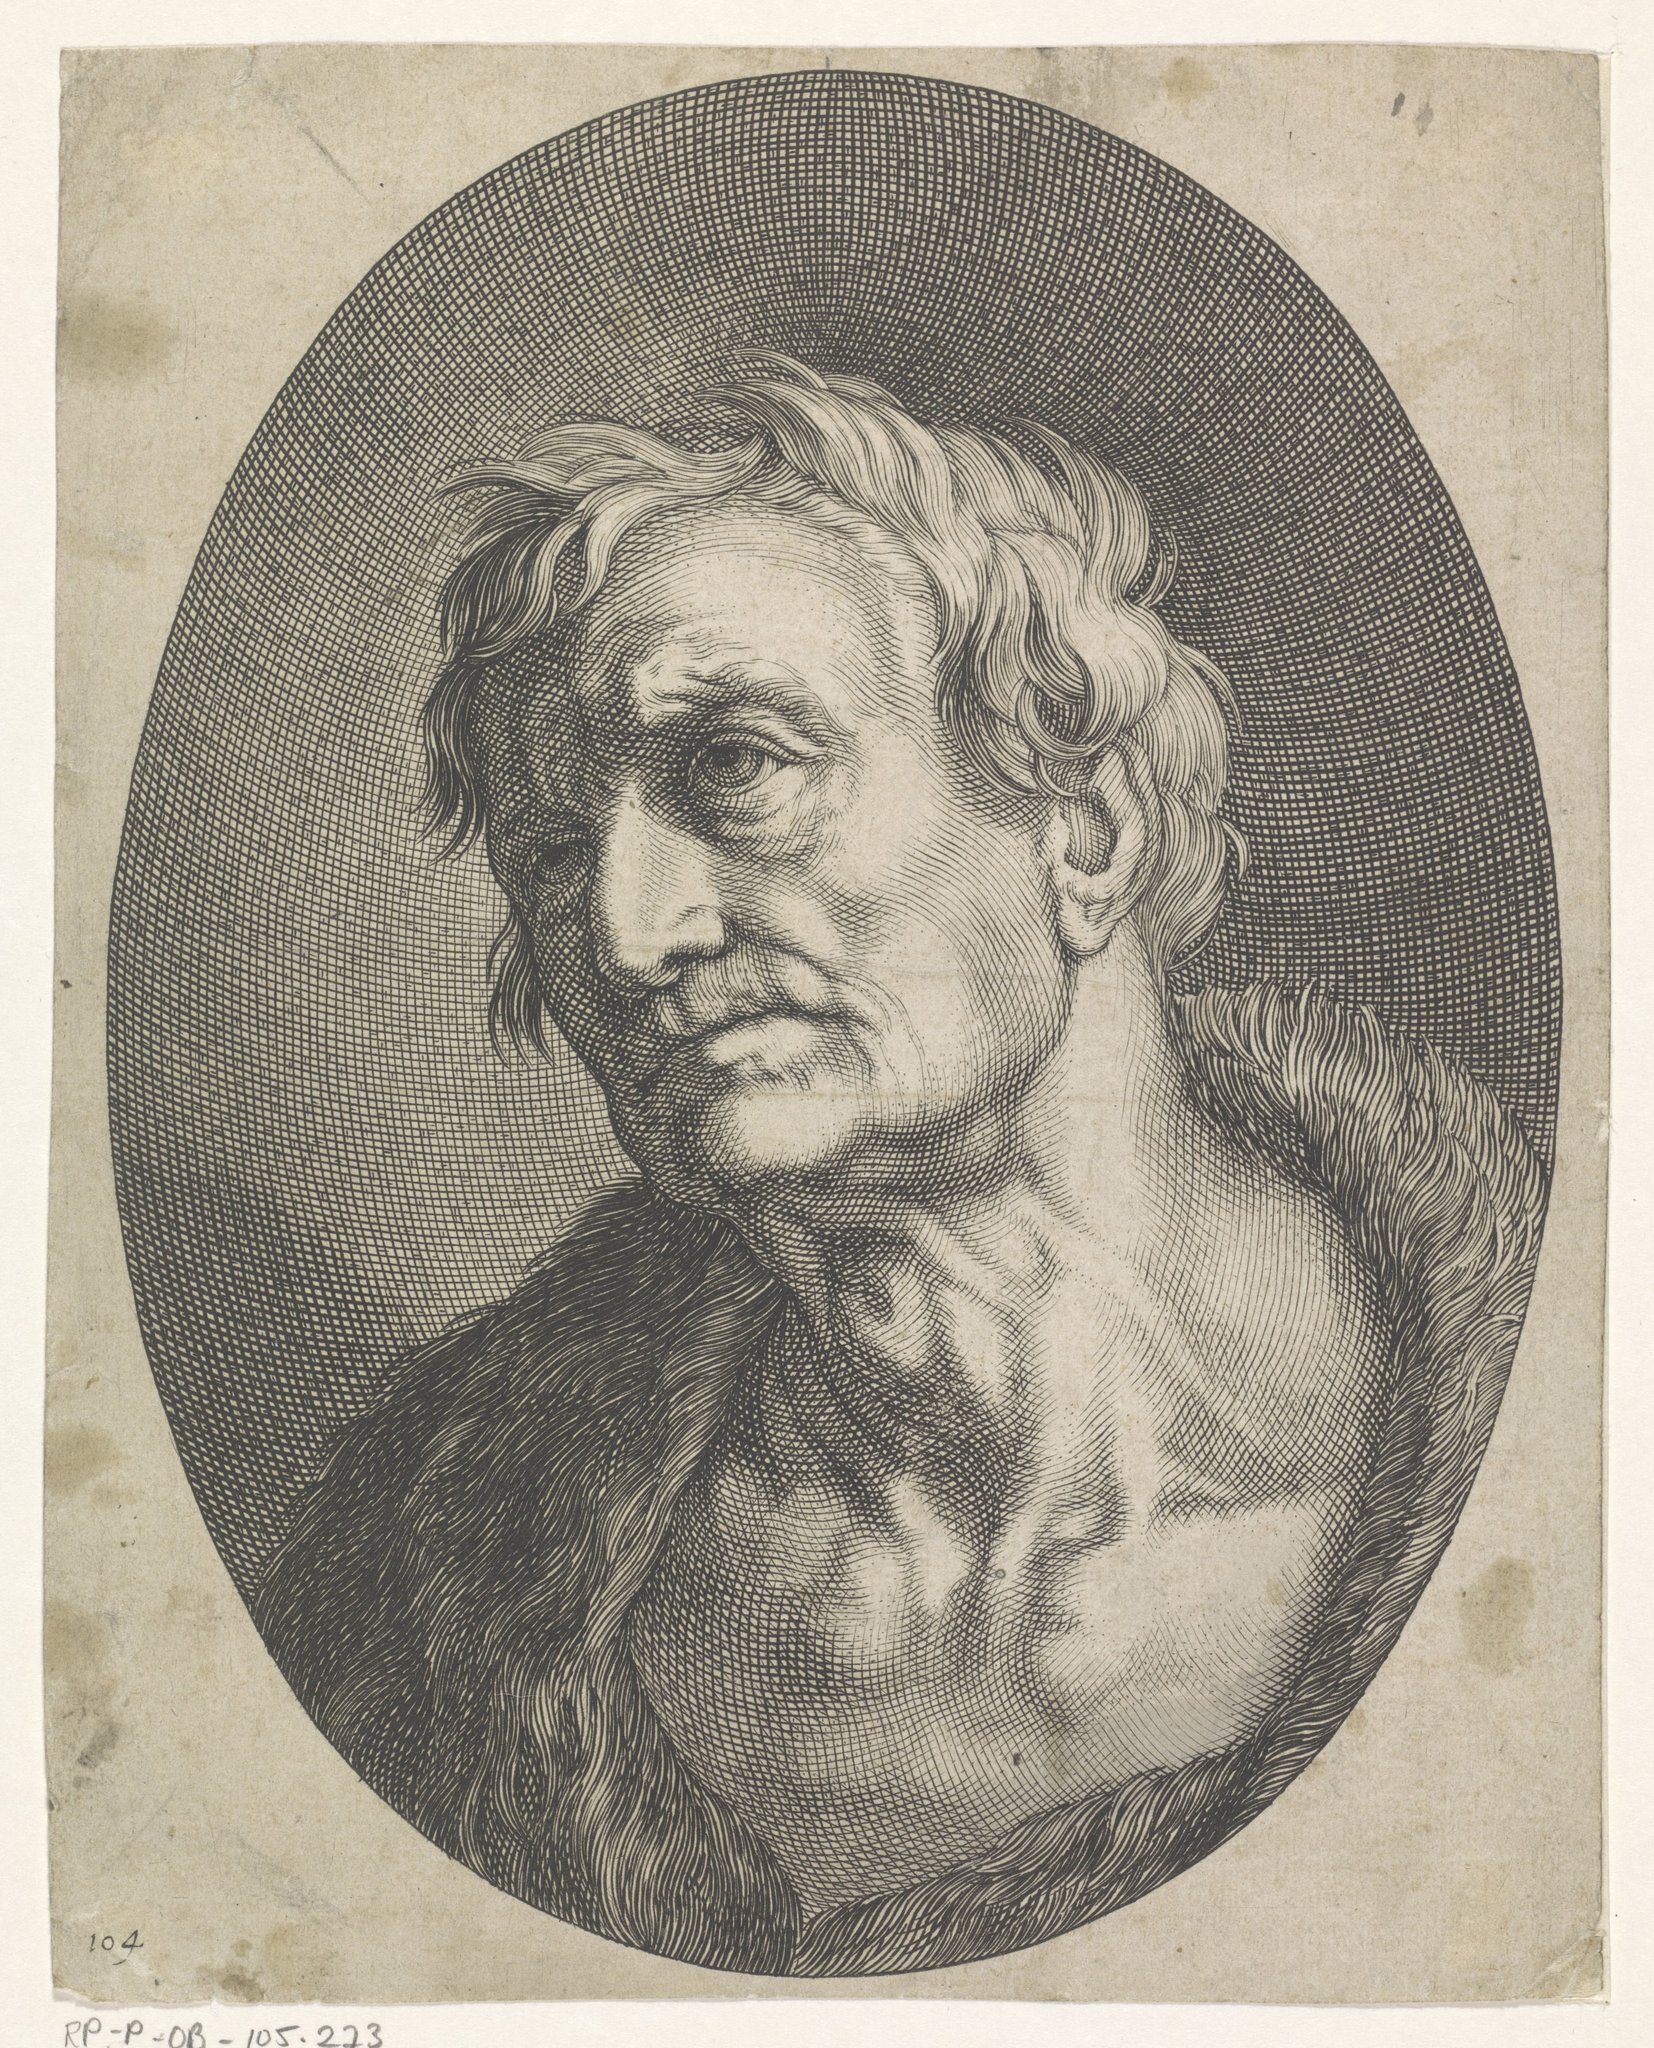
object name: print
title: Portret van een oude man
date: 1600-1700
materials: paper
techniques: engraving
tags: old man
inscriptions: collector's mark: Lugt 2228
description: Portret van een oude man, die omhoog kijkt. Om zijn schouders een bontvel. Linksonder genummerd: 104.